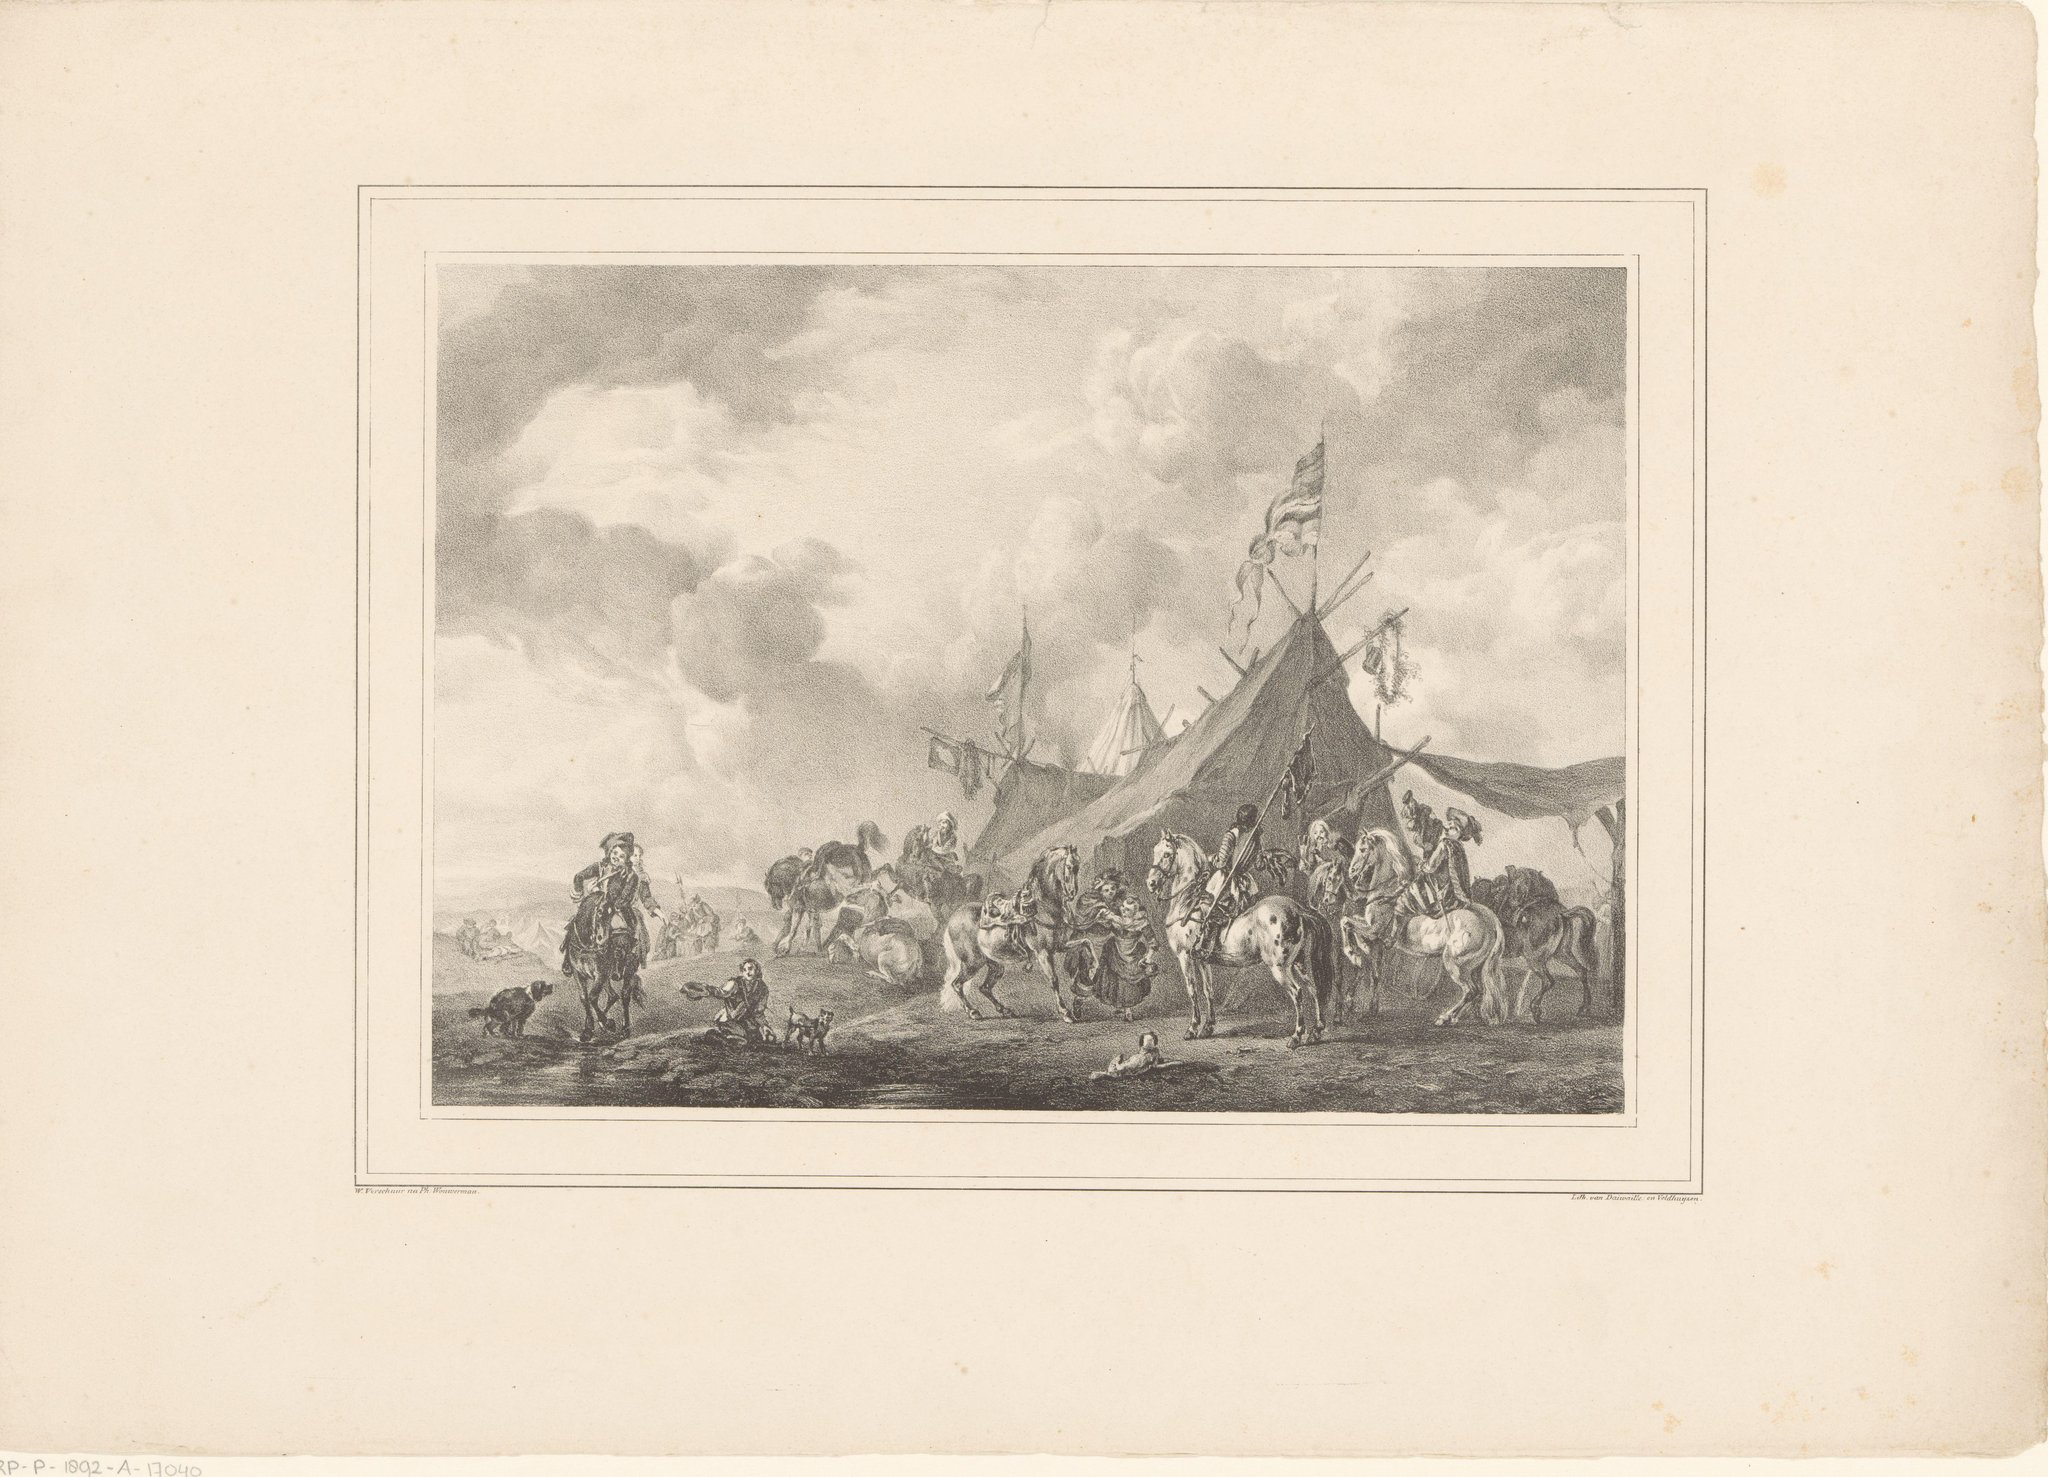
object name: print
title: Legerkamp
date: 1831-1832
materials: paper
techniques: lithograph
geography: netherlands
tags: (military) camp with tents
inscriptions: collector's mark: Lugt 2228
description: Een groep ruiters arriveert bij een tent die in gebruik is als herberg. Vandaar de bierpul aan de stok. Eén van de mannen blaast op zijn trompet, terwijl anderen al een liefje te pakken hebben.